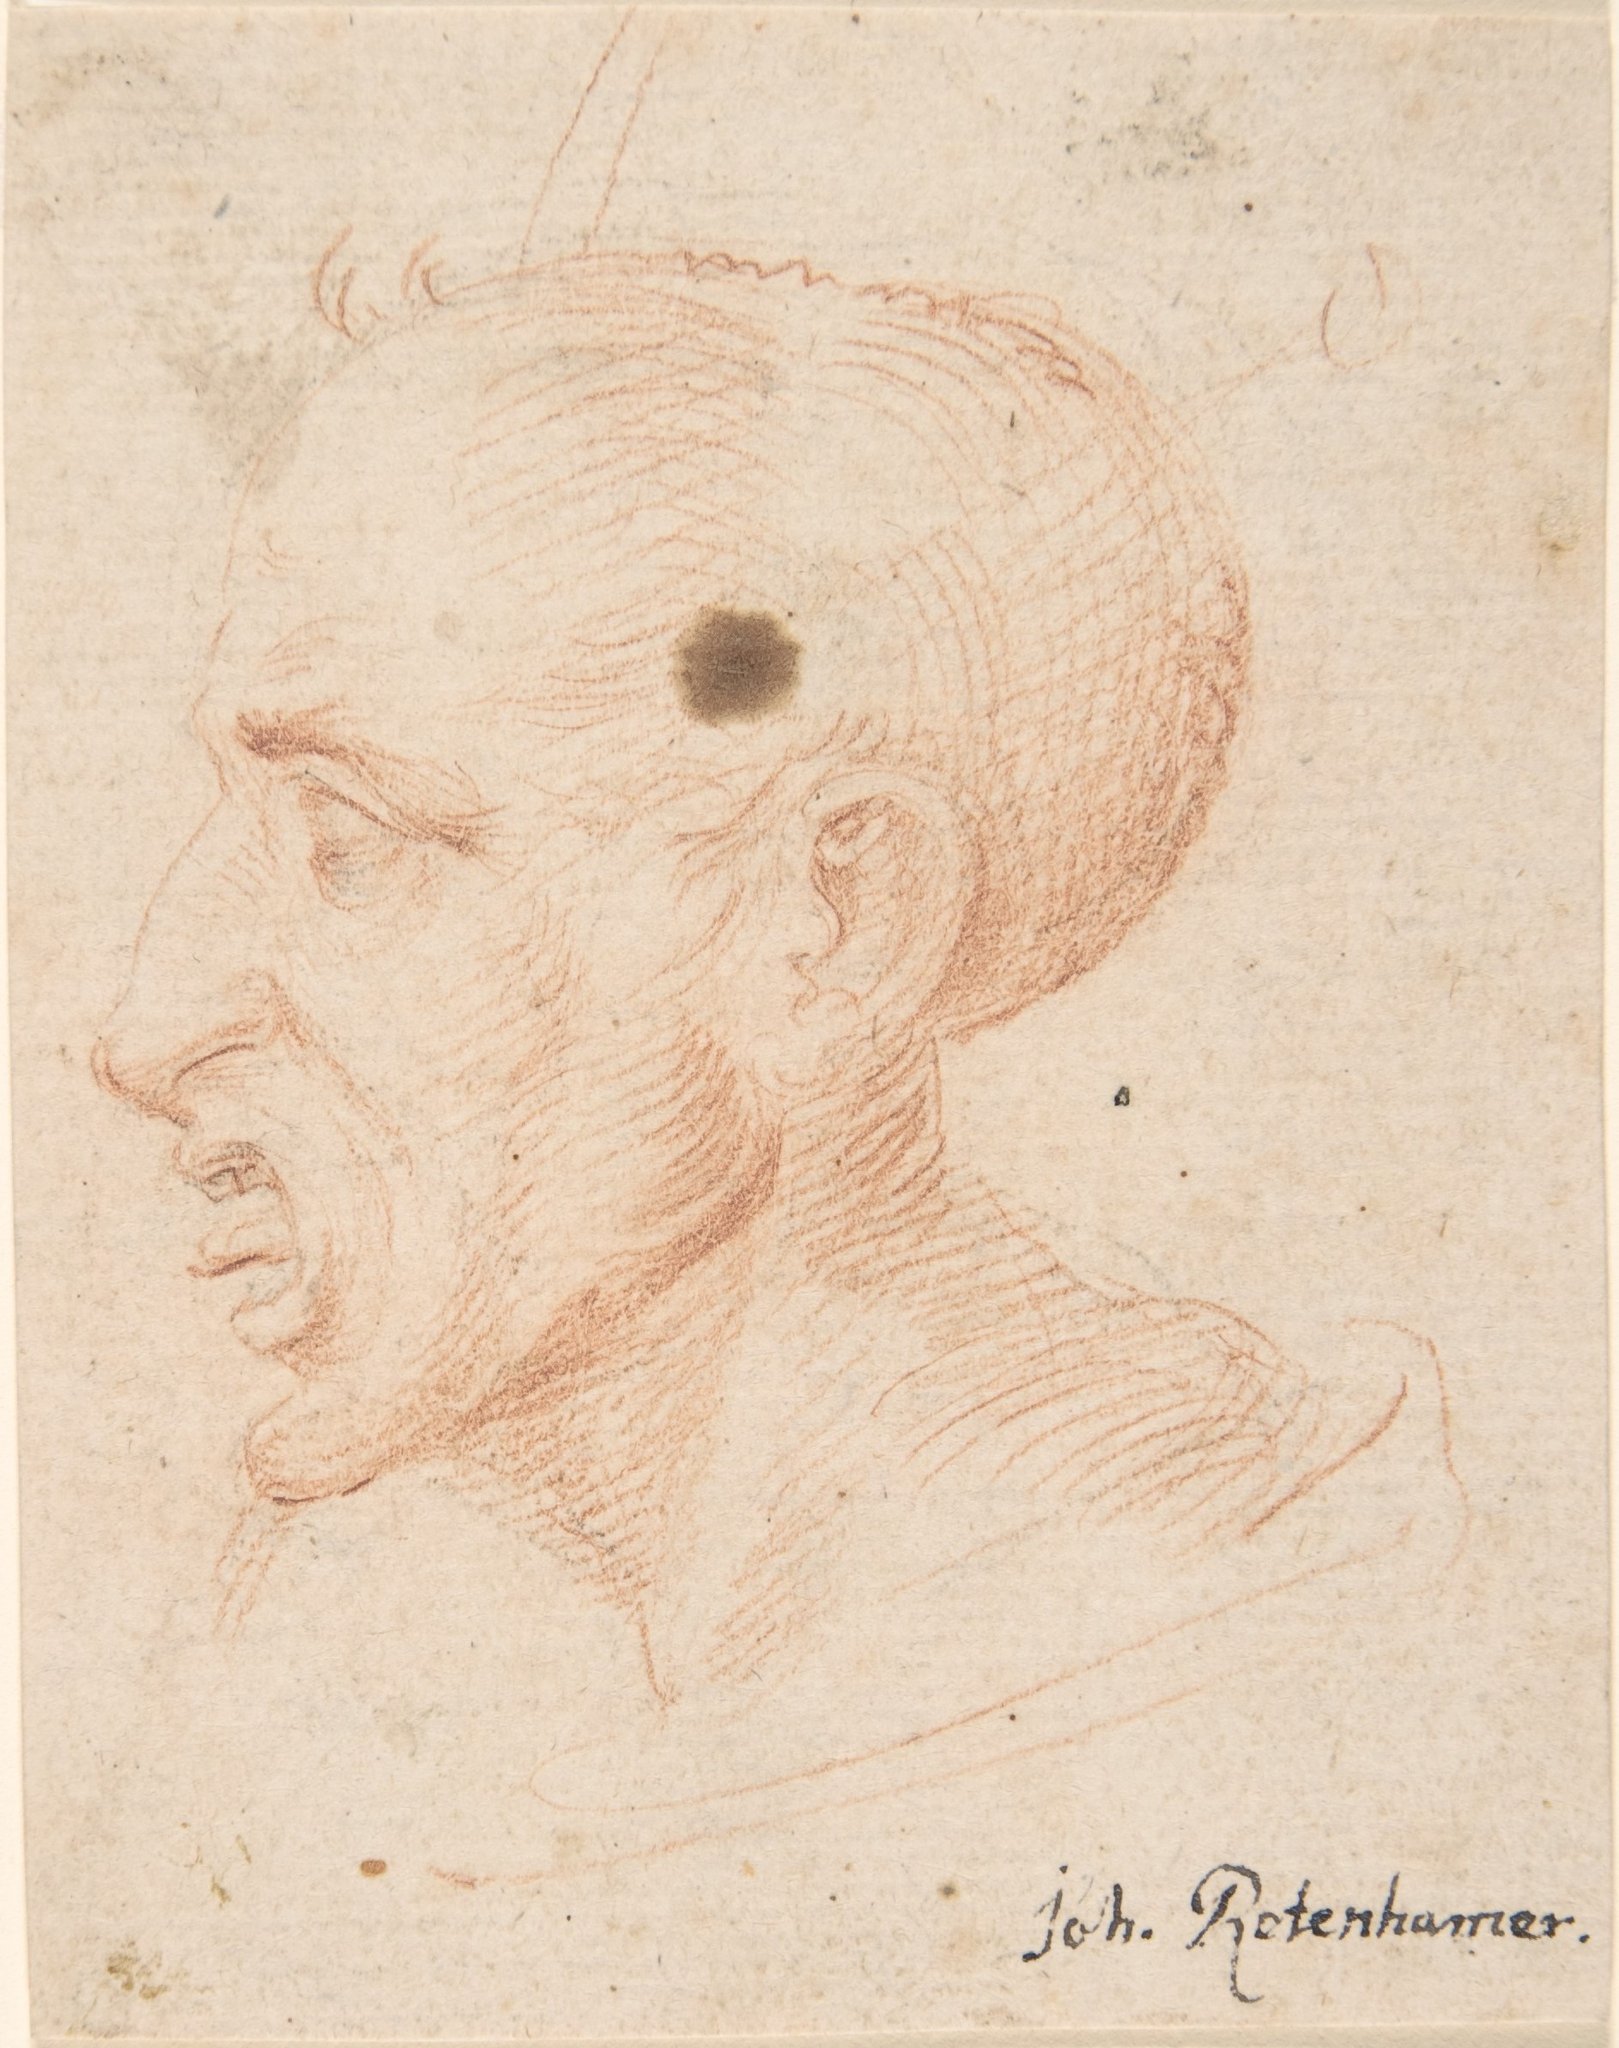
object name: drawing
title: Bust of a Man Looking Left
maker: anonymous, 17th century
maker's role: artist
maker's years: 1600-1700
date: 1601-1700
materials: chalk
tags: men,profiles